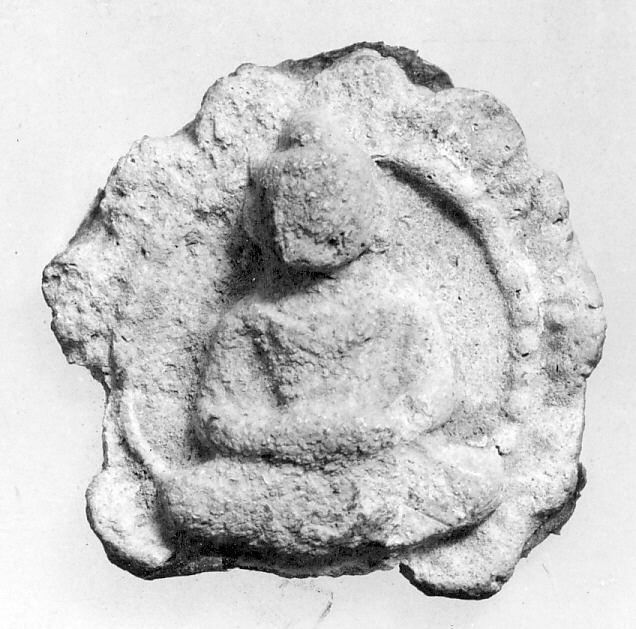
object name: relief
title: Relief of a Seated Buddha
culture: central asian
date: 201-700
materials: plaster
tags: buddhism,buddha